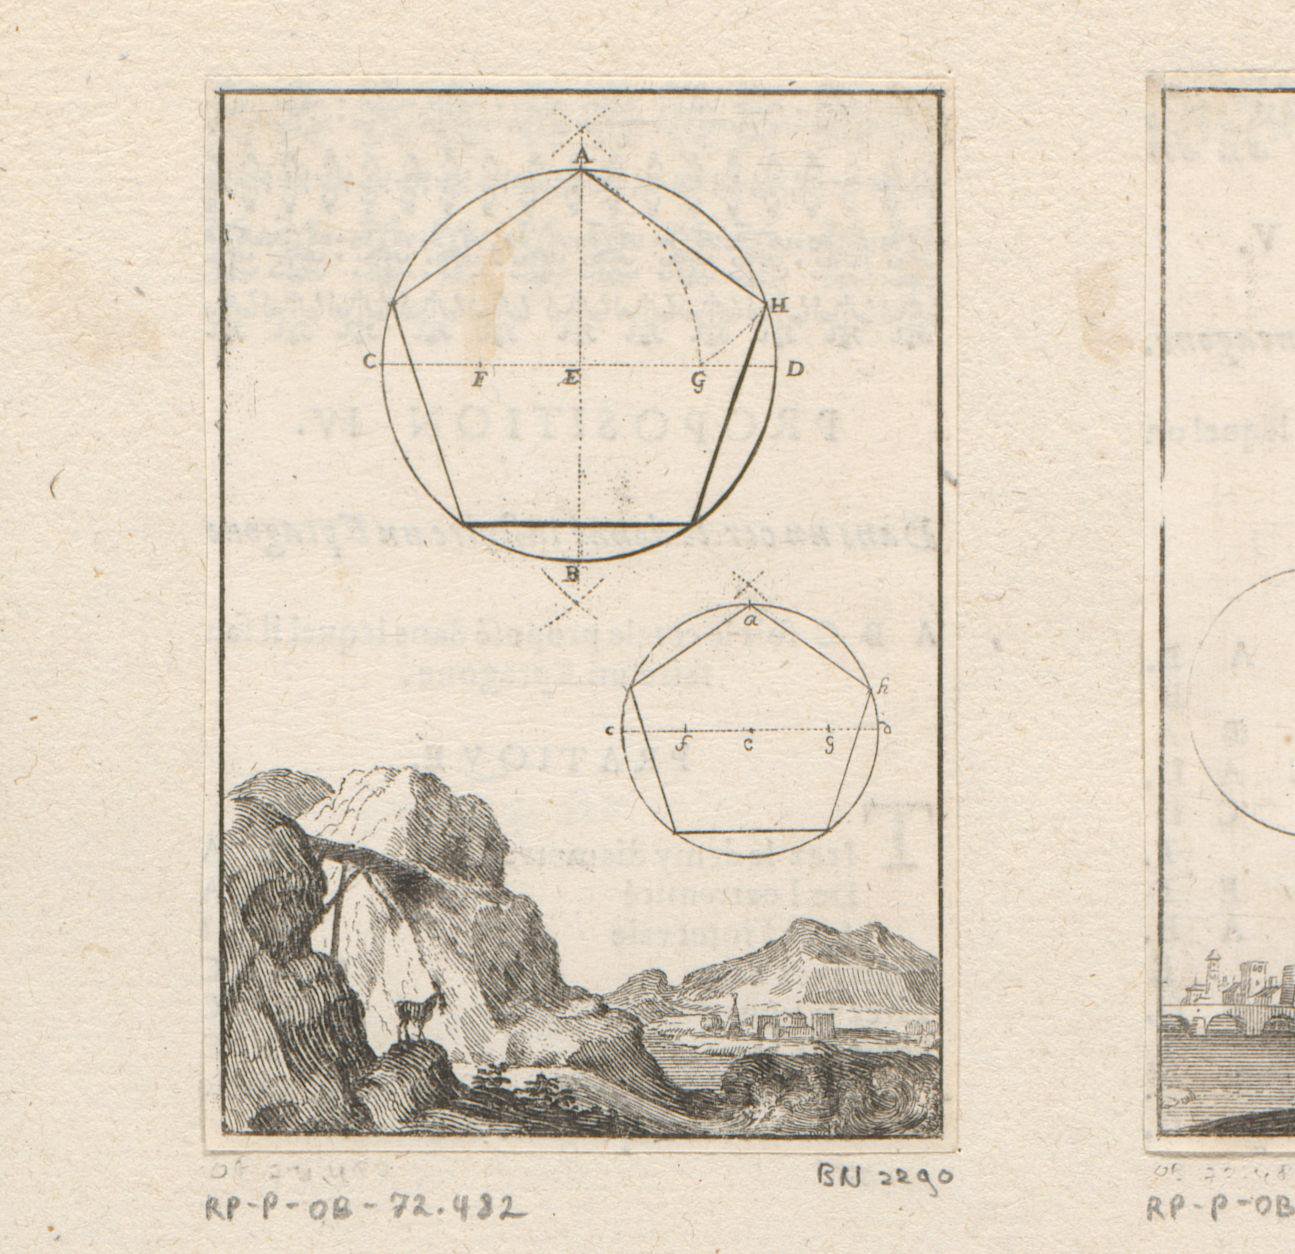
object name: print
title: Constructie van een vijfhoek in een cirkel met onderaan een berglandschap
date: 1669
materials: paper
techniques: etching, letterpress printing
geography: france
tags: planimetry, geometry, mountains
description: Prent uit: Pratique de la géometrie, sur le papier et sur le terrain. Avec un nouvel ordre et une méthode particulière. Parijs: Thomas Jolly, 1669.